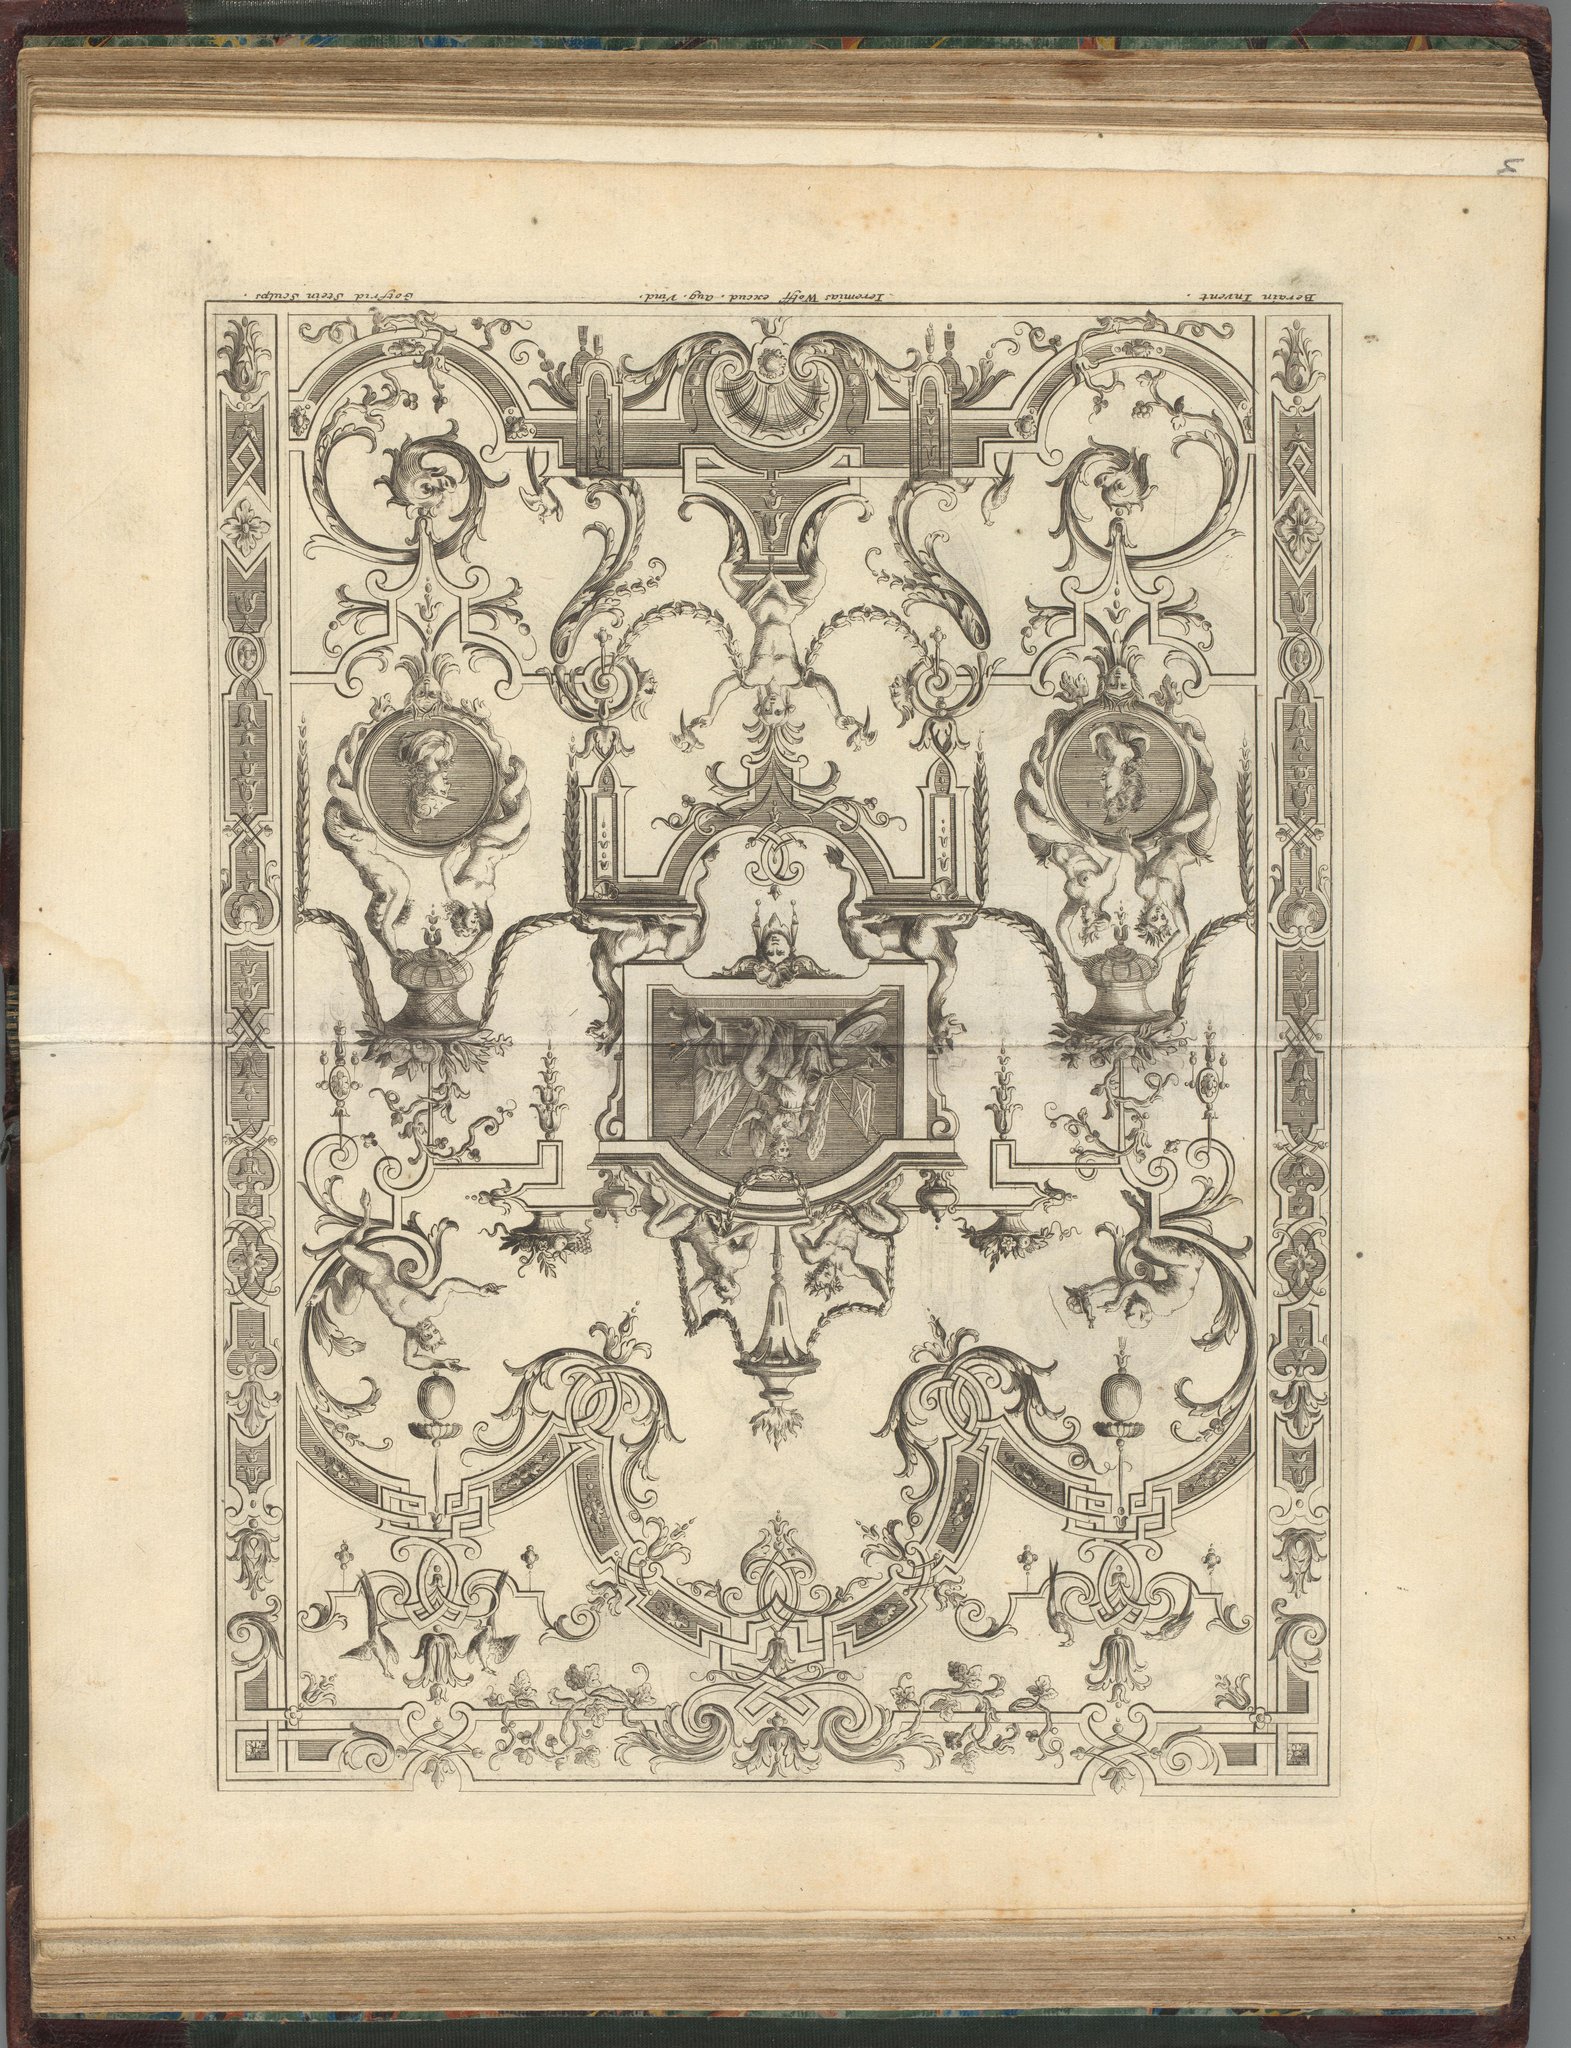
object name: print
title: Compositie met engel met bazuin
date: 1697-1724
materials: paper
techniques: etching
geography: augsburg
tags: ornaments ~ art, horn, trumpet, cornet, trombone, tuba, satyr(s) (in general)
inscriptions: signature: ‘Ieremias Wolff excud. Aug. Vind.’, signature: ‘Berain Invent.’, signature: ‘Gotfrid Stein Sculps’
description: Een decoratieve compositie met vlechtwerk en drie arcades. In het midden een engel met bazuin en vlaggen met daarboven satyrs. Prent maakt deel uit van een album. Hoogstwaarschijnlijk gespiegelde kopie naar Frans origineel.